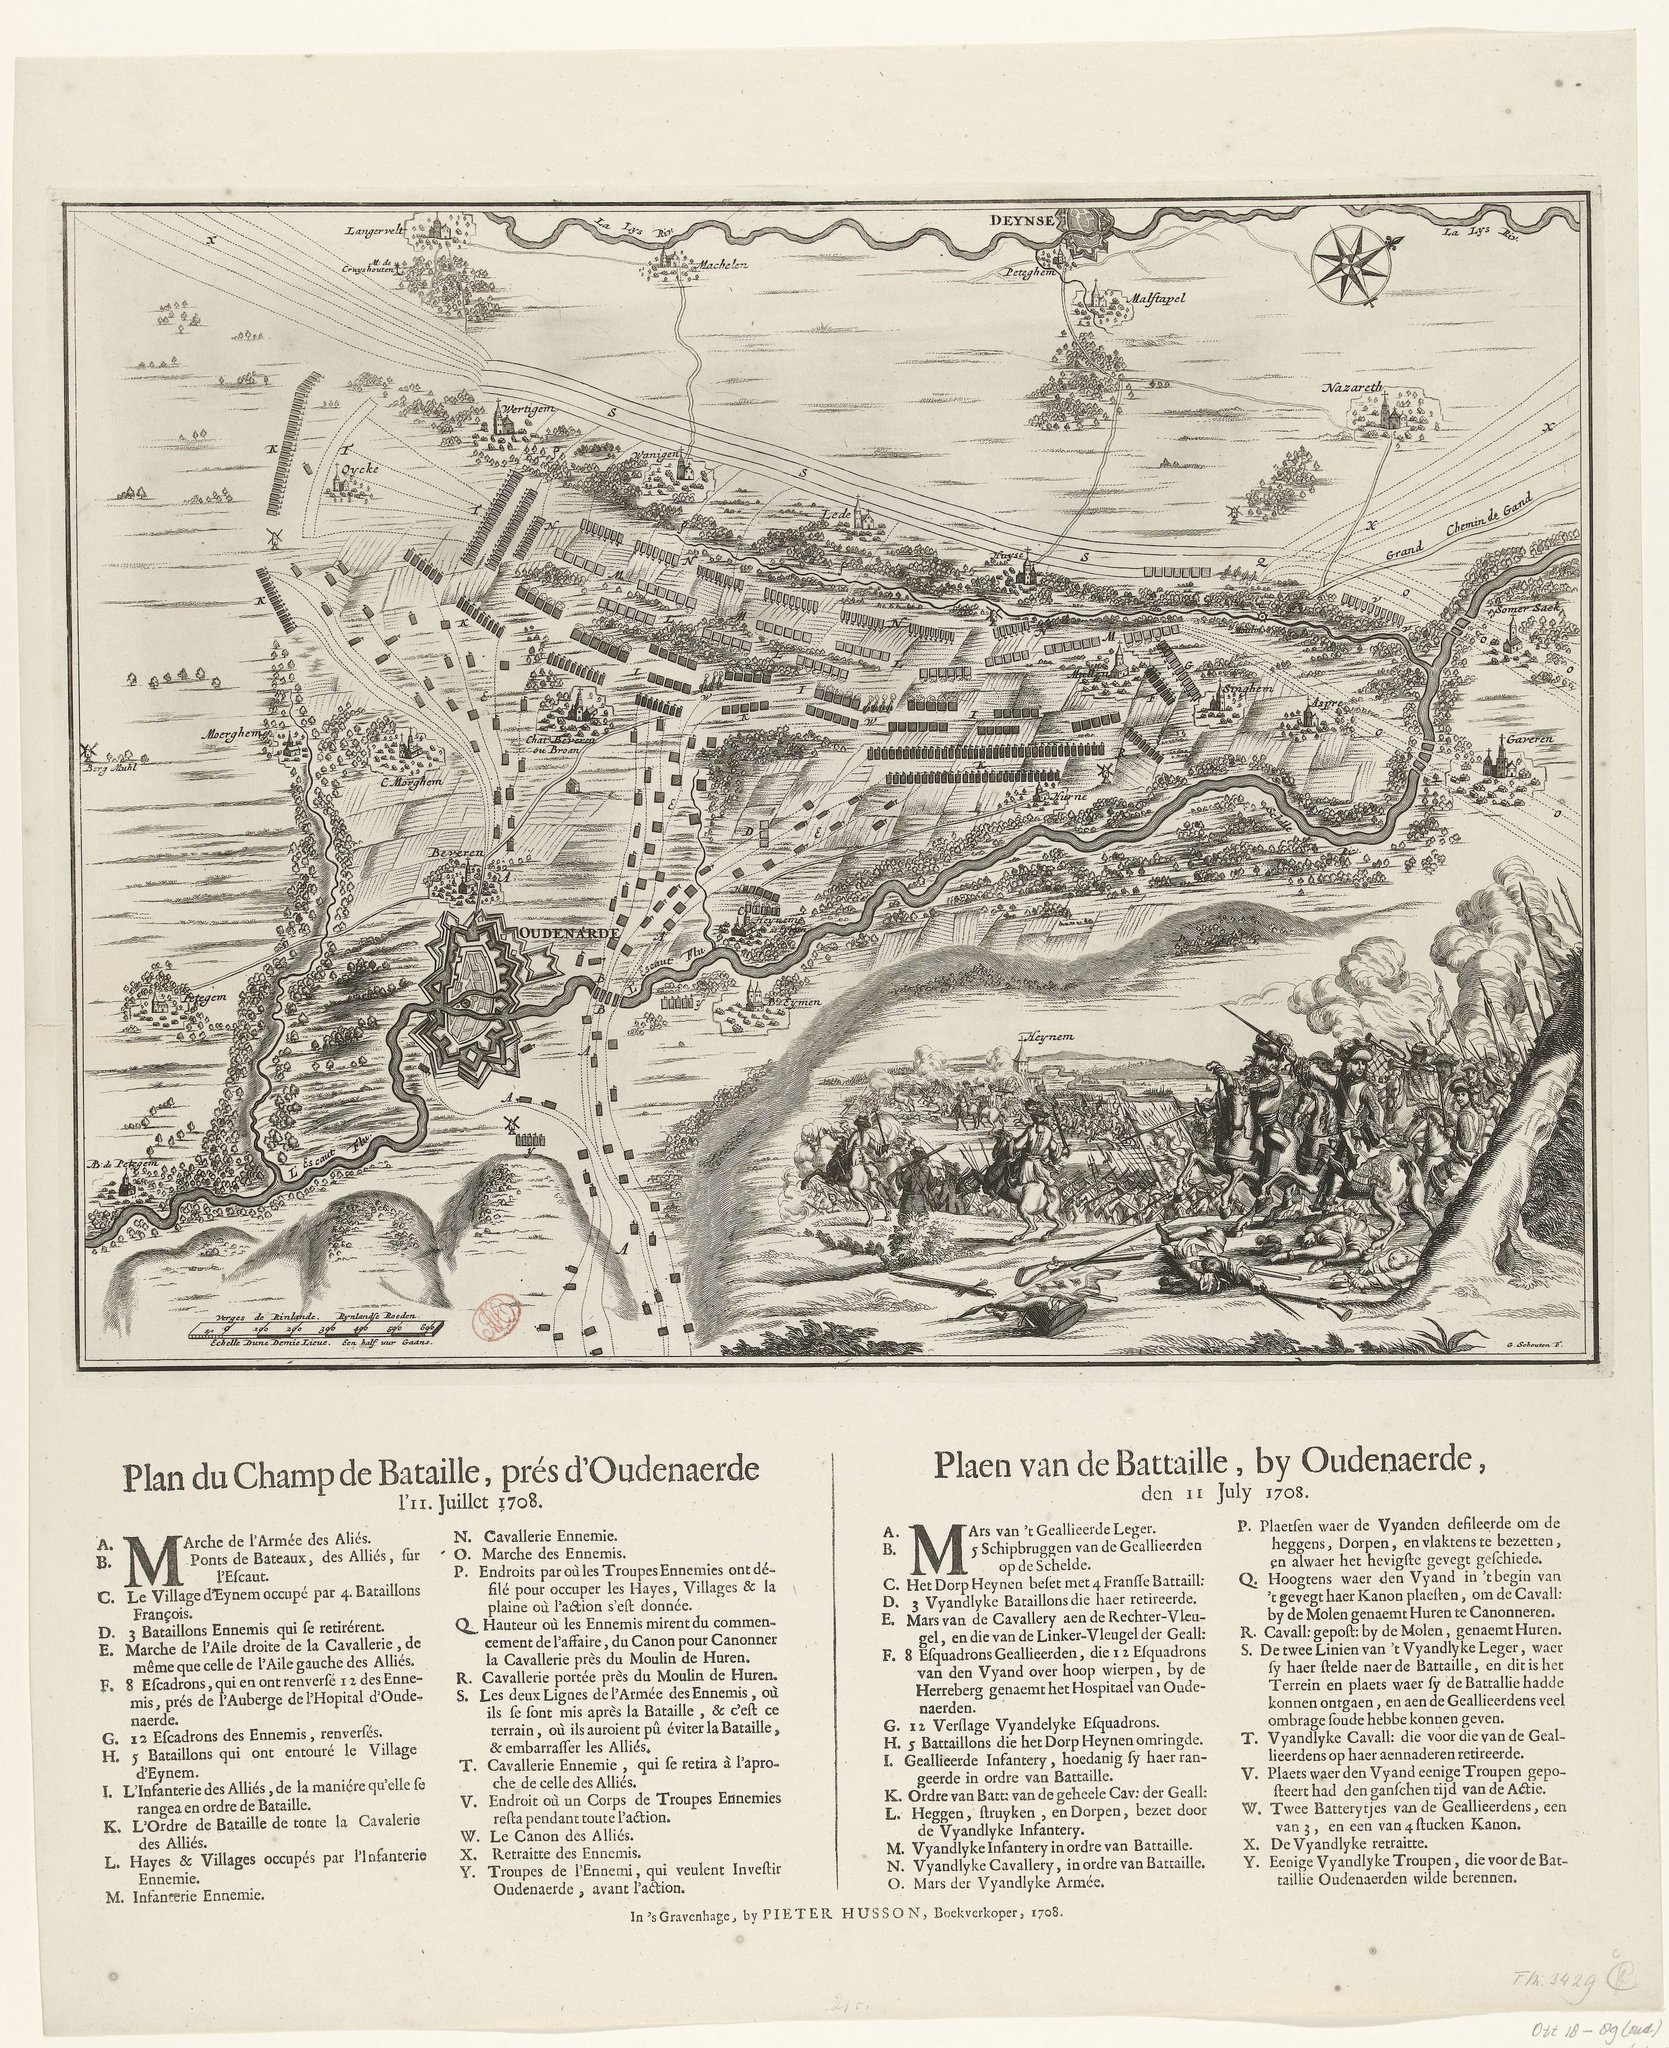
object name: print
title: Slag bij Oudenaarde, 1708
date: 1708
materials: paper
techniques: etching, letterpress printing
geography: the hague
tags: maps of separate countries or regions, battle (+ land forces)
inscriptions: collector's mark: Lugt 195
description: Plan van de veldslag bij Oudenaarde tussen de Geallieerden onder de prins van Savoye en de hertog van Marlborough en de Fransen, 11 juli 1708. Rechtsonder een scène waarin de legeraanvoerders hun troepen ten strijde voeren. Vastgeplakt onder de plaat een blad met de legenda's A-Y in het Frans en Nederlands.